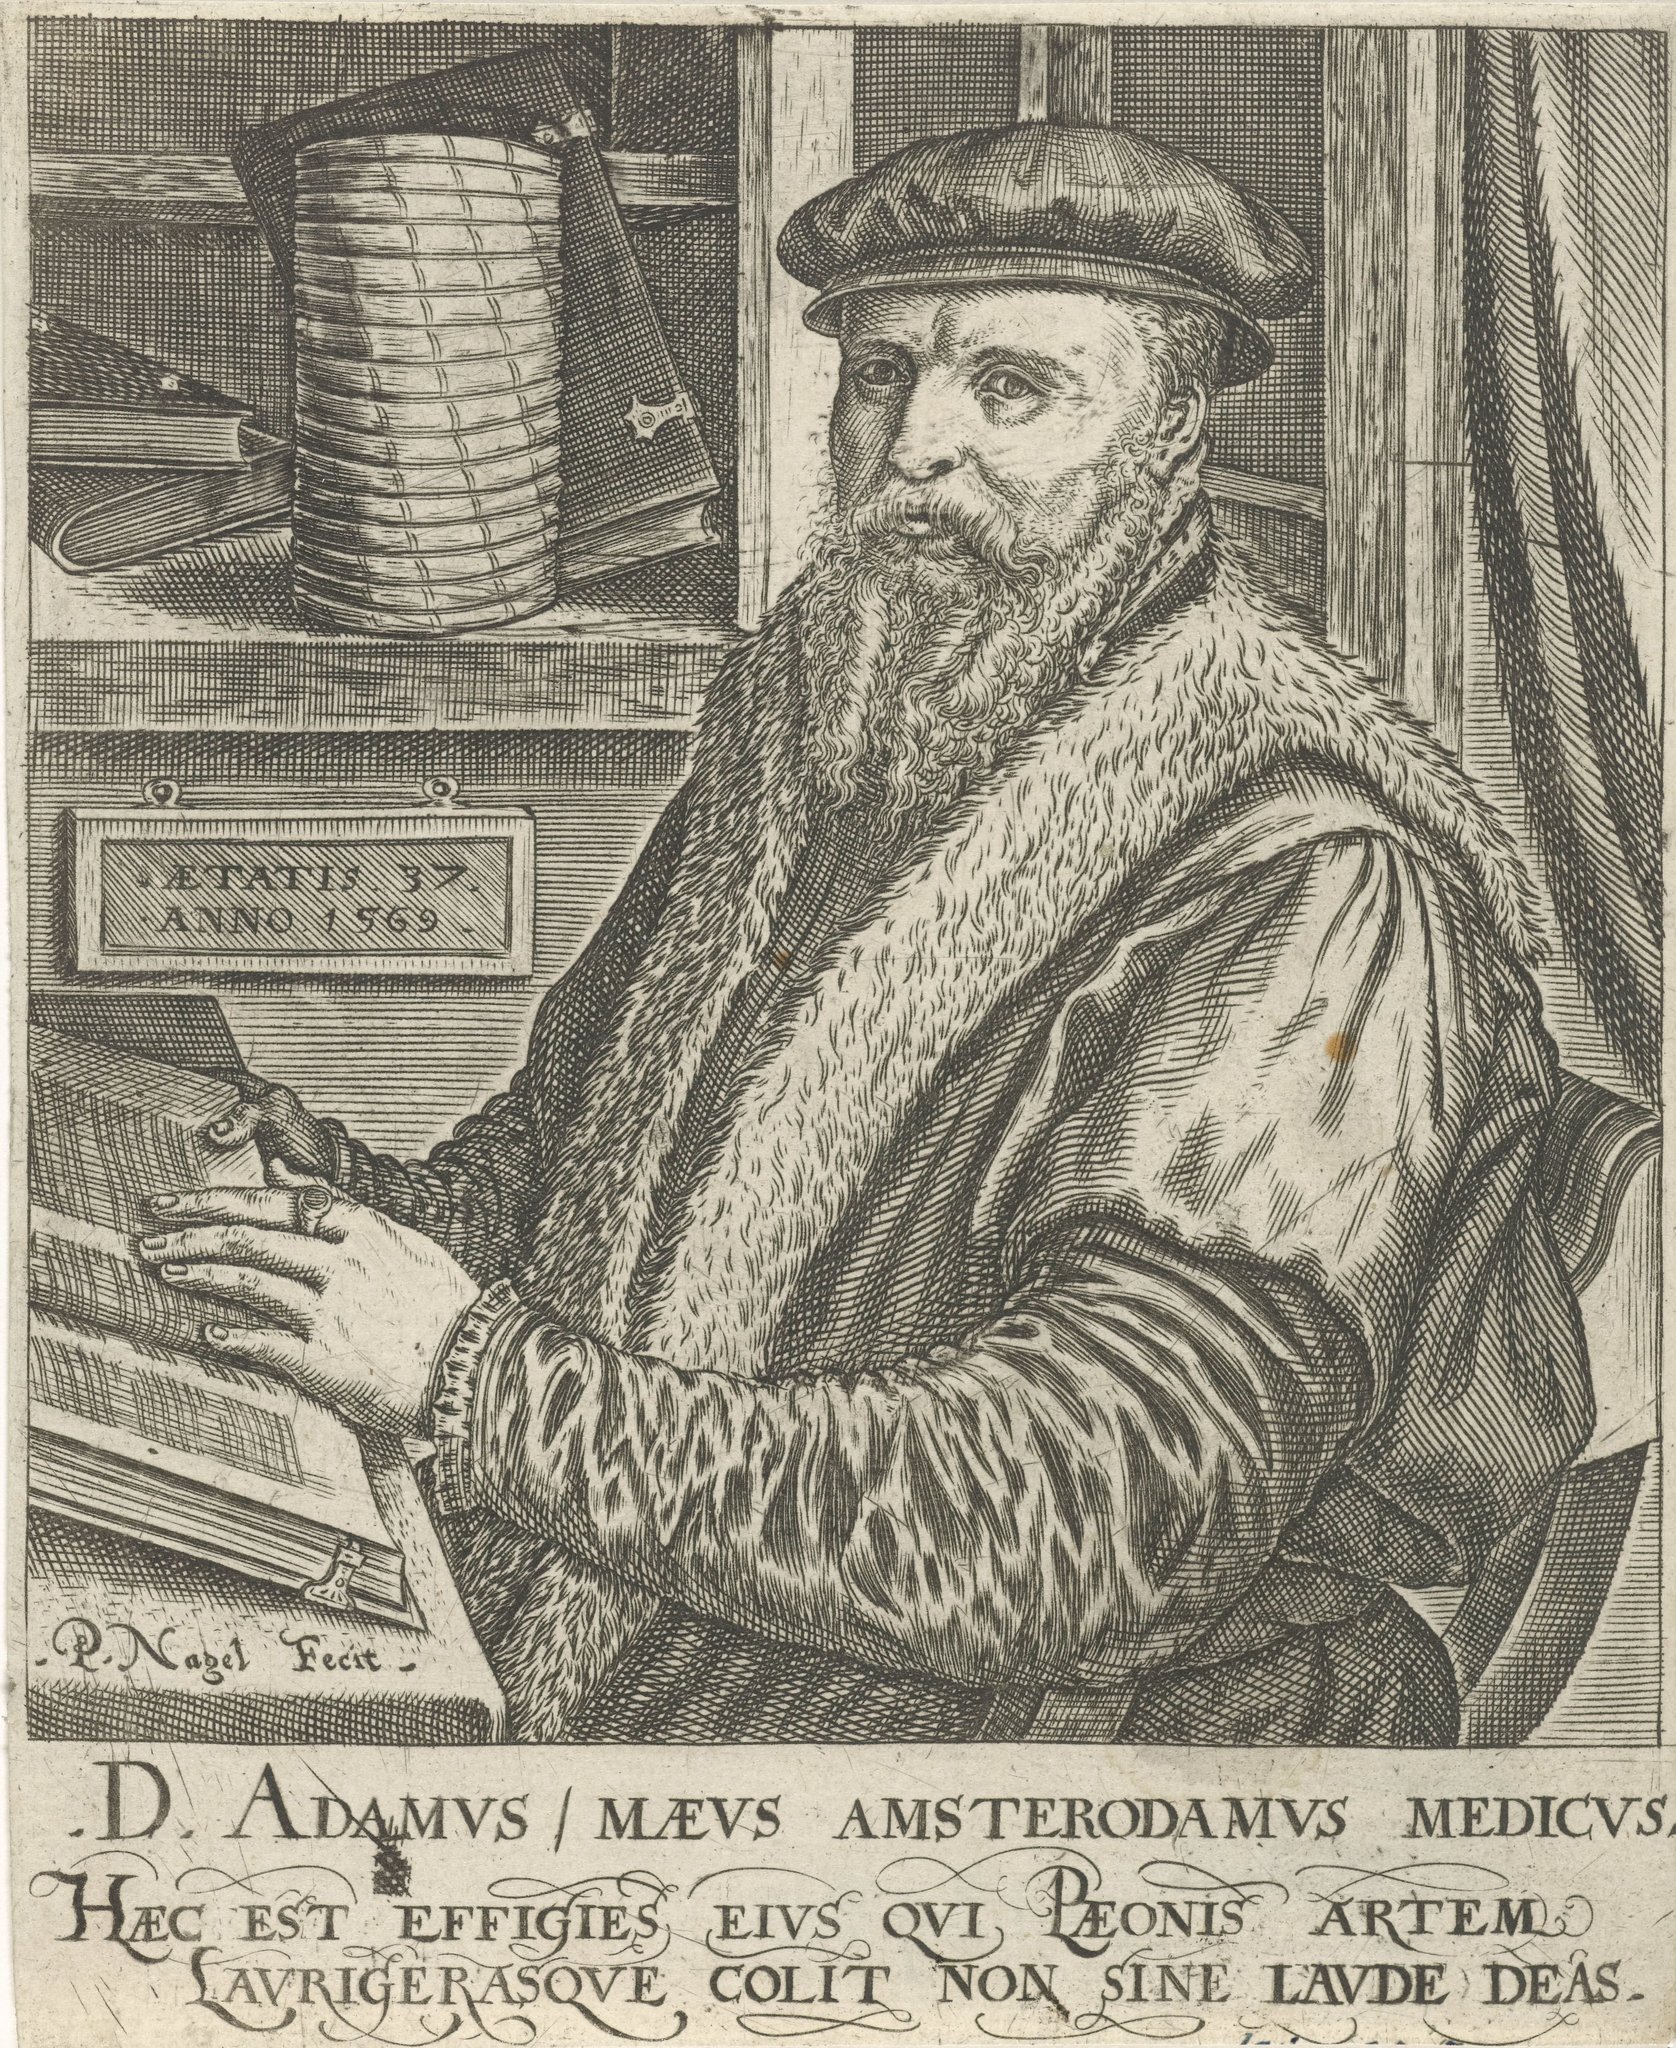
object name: print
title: Portret van Adam Maeus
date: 1569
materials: paper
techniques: engraving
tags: arts, adam maeus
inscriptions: collector's mark: Lugt 2228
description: Adam Maeus zittend aan een tafel, zijn handen op een opengeslagen boek. Onder in de marge een tweeregelige tekst in het Latijn.